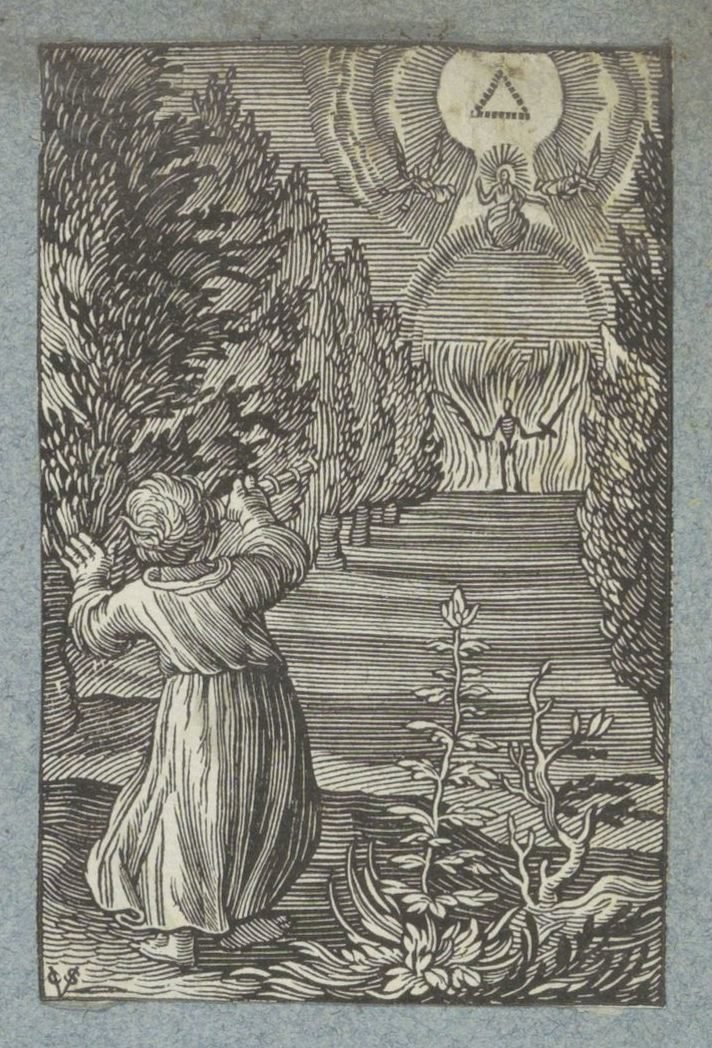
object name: print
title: Pia Desideria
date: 1628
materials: paper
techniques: woodcut, pasting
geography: amsterdam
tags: last judgement, death as skeleton, garden, binoculars, spy-glass, etc.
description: Prent uit: Herman Hugo, Pia desideria emblematis, elegiis & affectibus S. S. Patrum illustrata, Antwerpen 1628. Volgens de titelpagina verscheen dit werk in Antwerpen bij Hendrick Aertssens, in werkelijkheid verscheen het in Amsterdam bij Pieter Jacobsz Paets (Dietz 2012, p. 58-59).